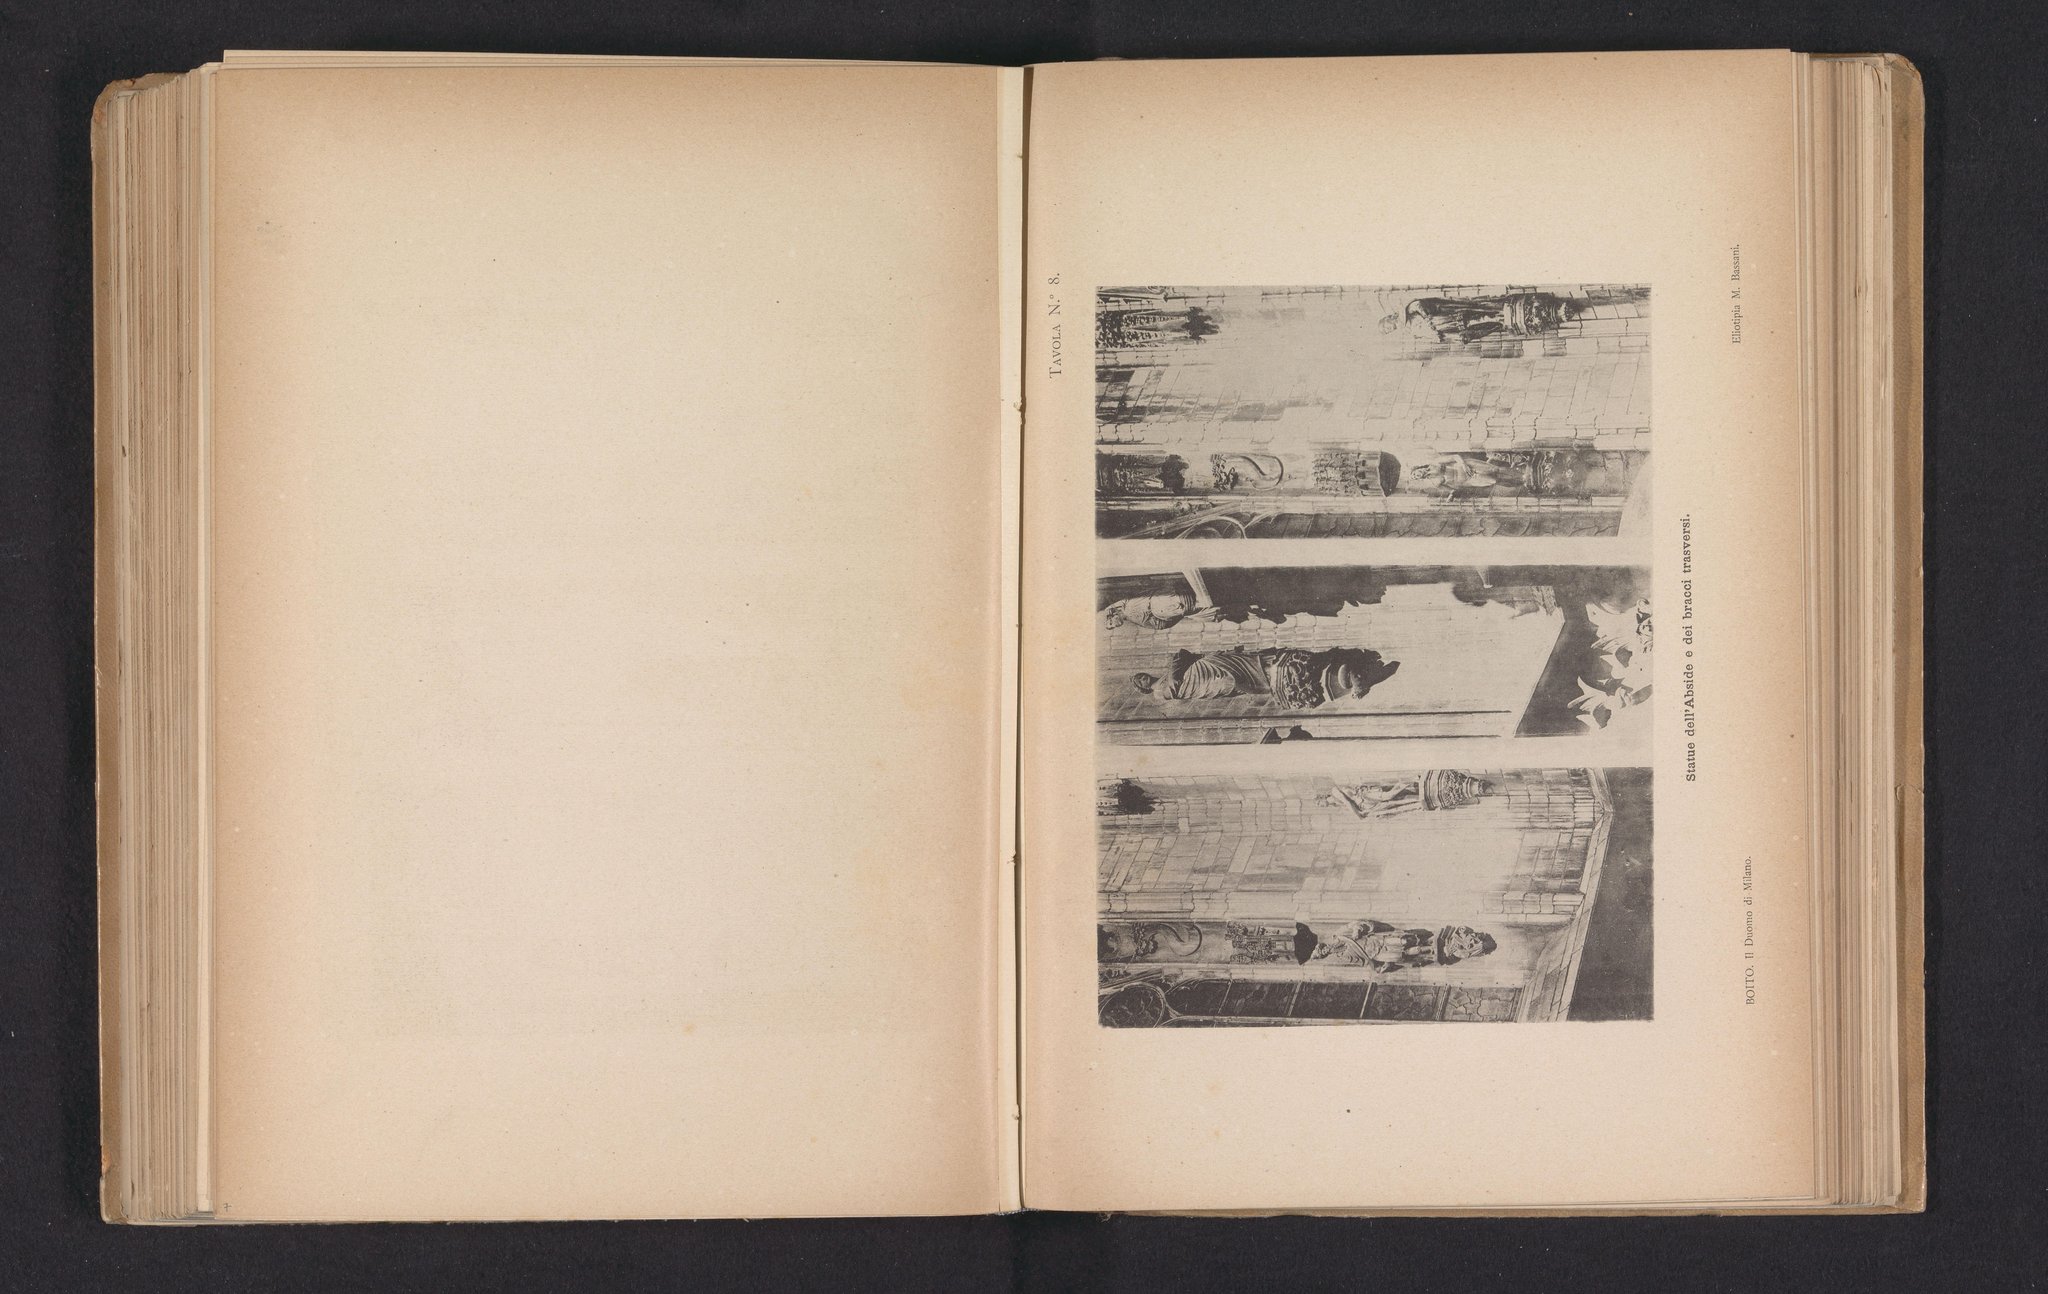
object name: page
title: Statue dell'Abside e dei bracci trasversi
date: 1879-1889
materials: paper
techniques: photograph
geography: milan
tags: parts of church interior: apse, church (exterior), piece of sculpture, reproduction of a piece of sculpture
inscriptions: number: ‘Tavola No. 8.’